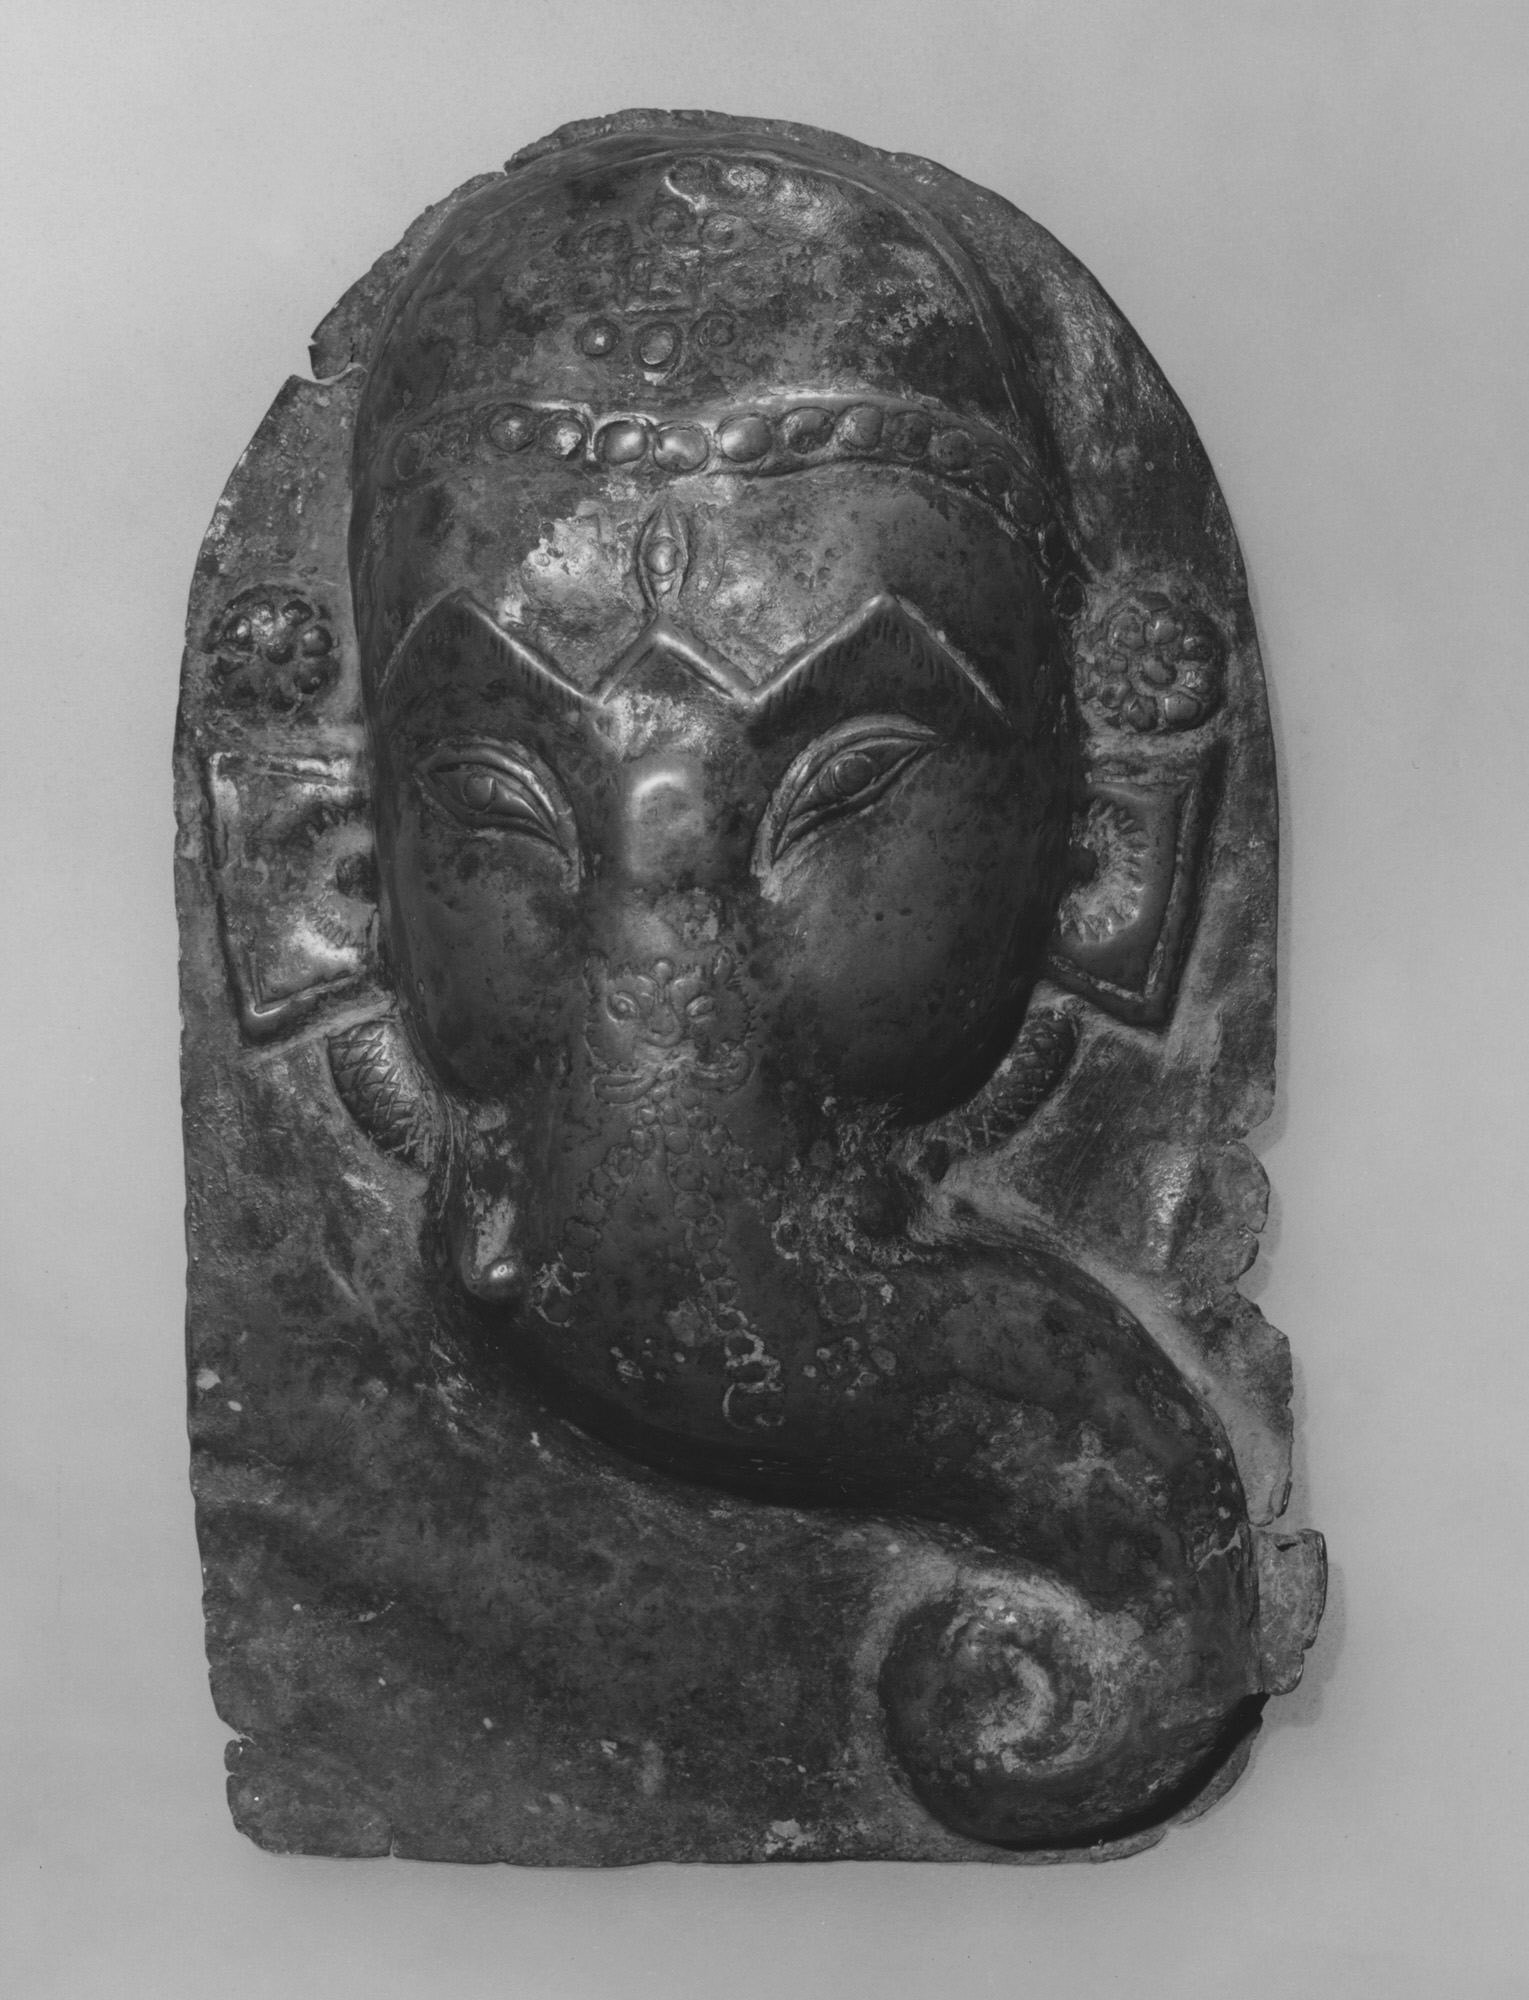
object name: relief plaque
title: Relief Plaque of Hindu Deity, Probably Processional: Face of Ganesha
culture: nepali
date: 1301-1600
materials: copper alloy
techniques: repoussé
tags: ganesha,hinduism